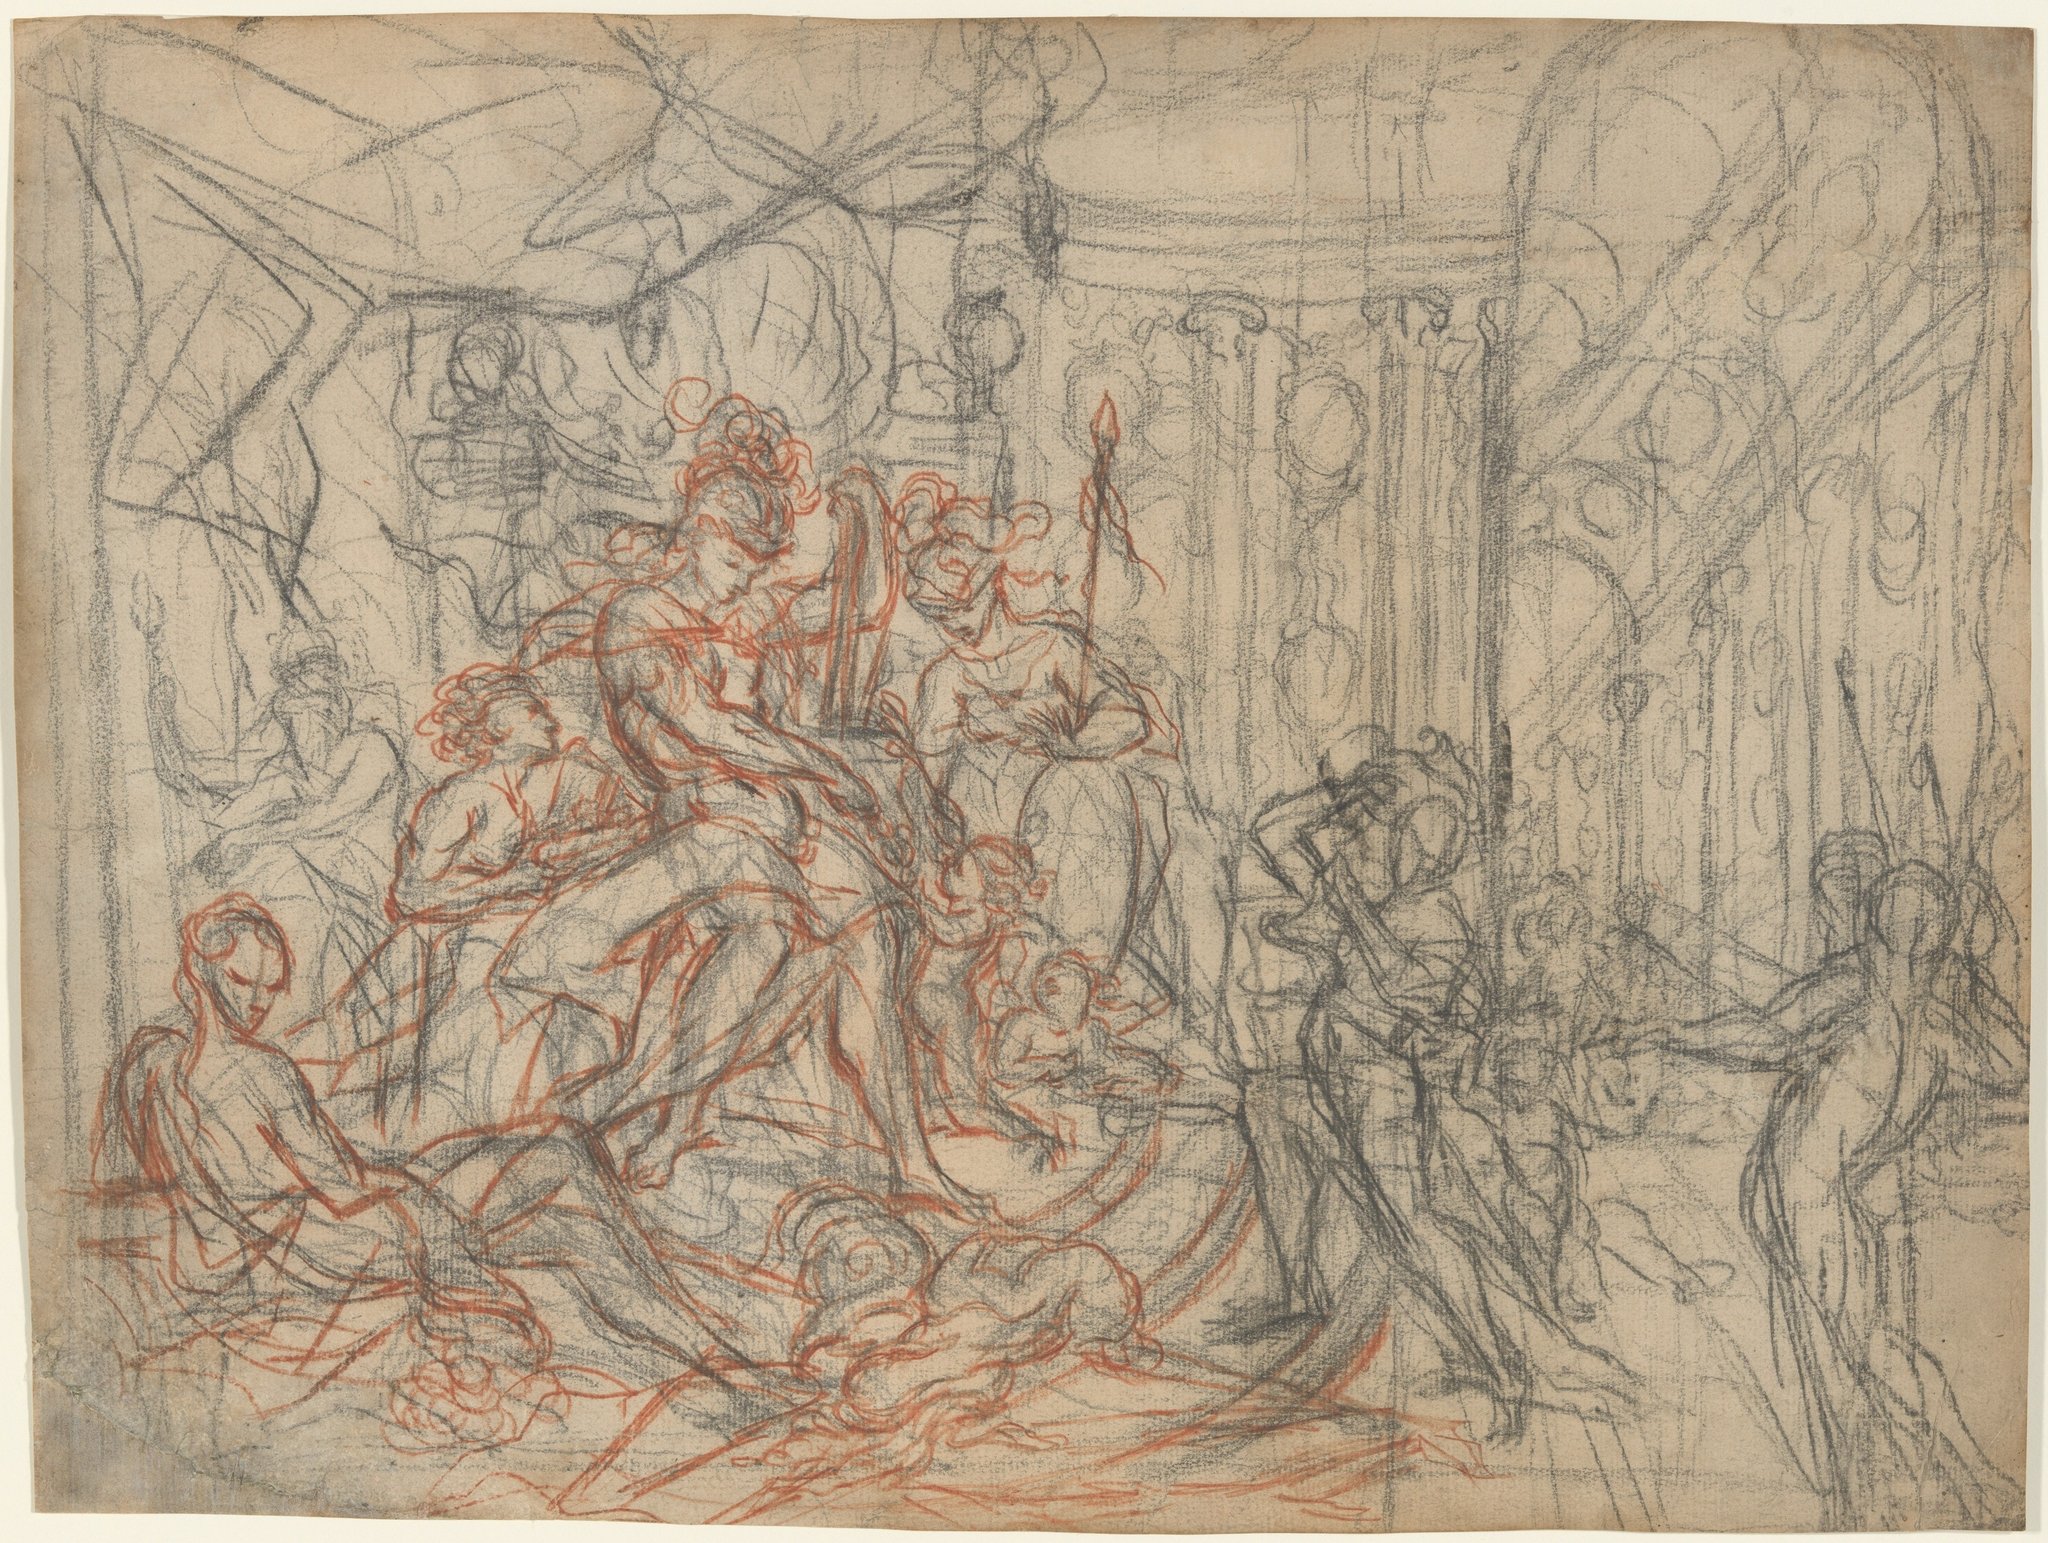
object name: drawing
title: The Arming of Bellona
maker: laurent hubert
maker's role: artist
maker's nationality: french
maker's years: 1780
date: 1701-1800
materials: chalk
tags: human figures